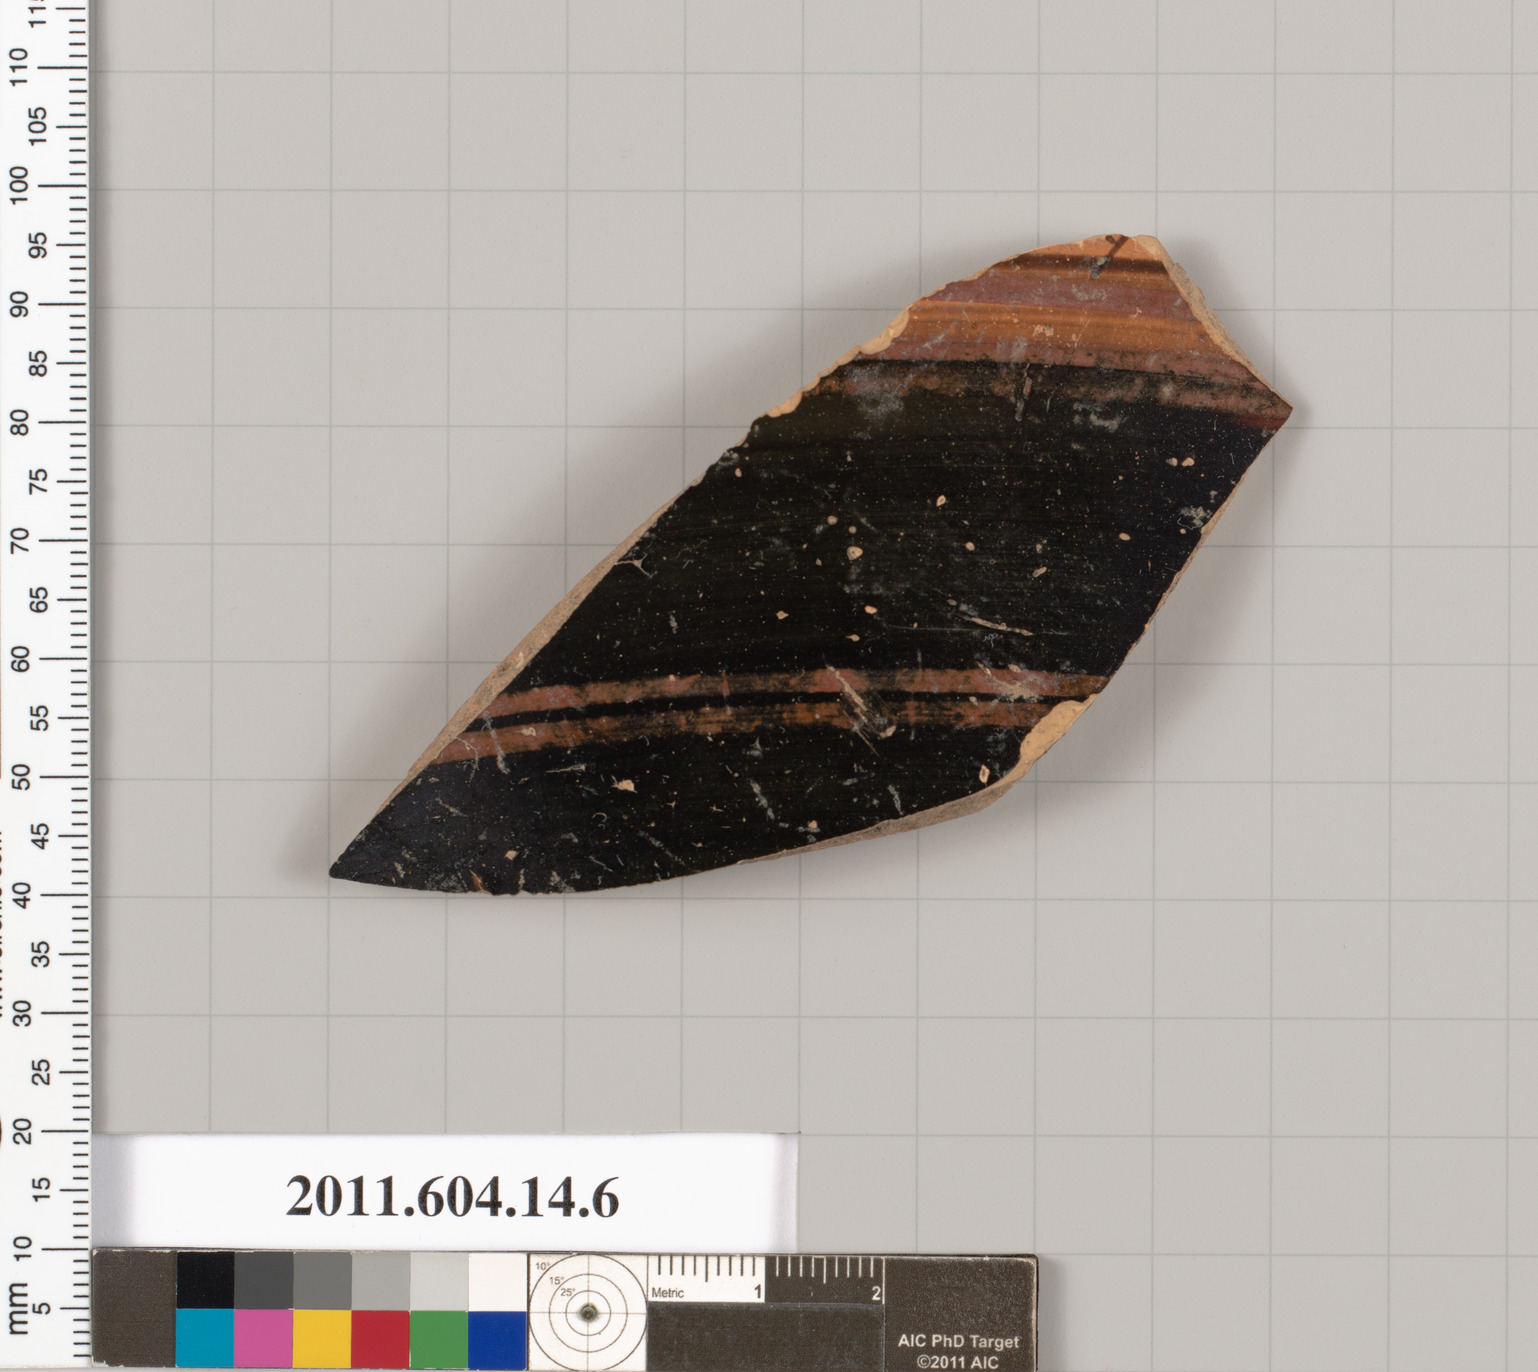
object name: amphora fragment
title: Terracotta fragment of an amphora?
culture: unknown fabric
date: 600-501 BCE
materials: terracotta